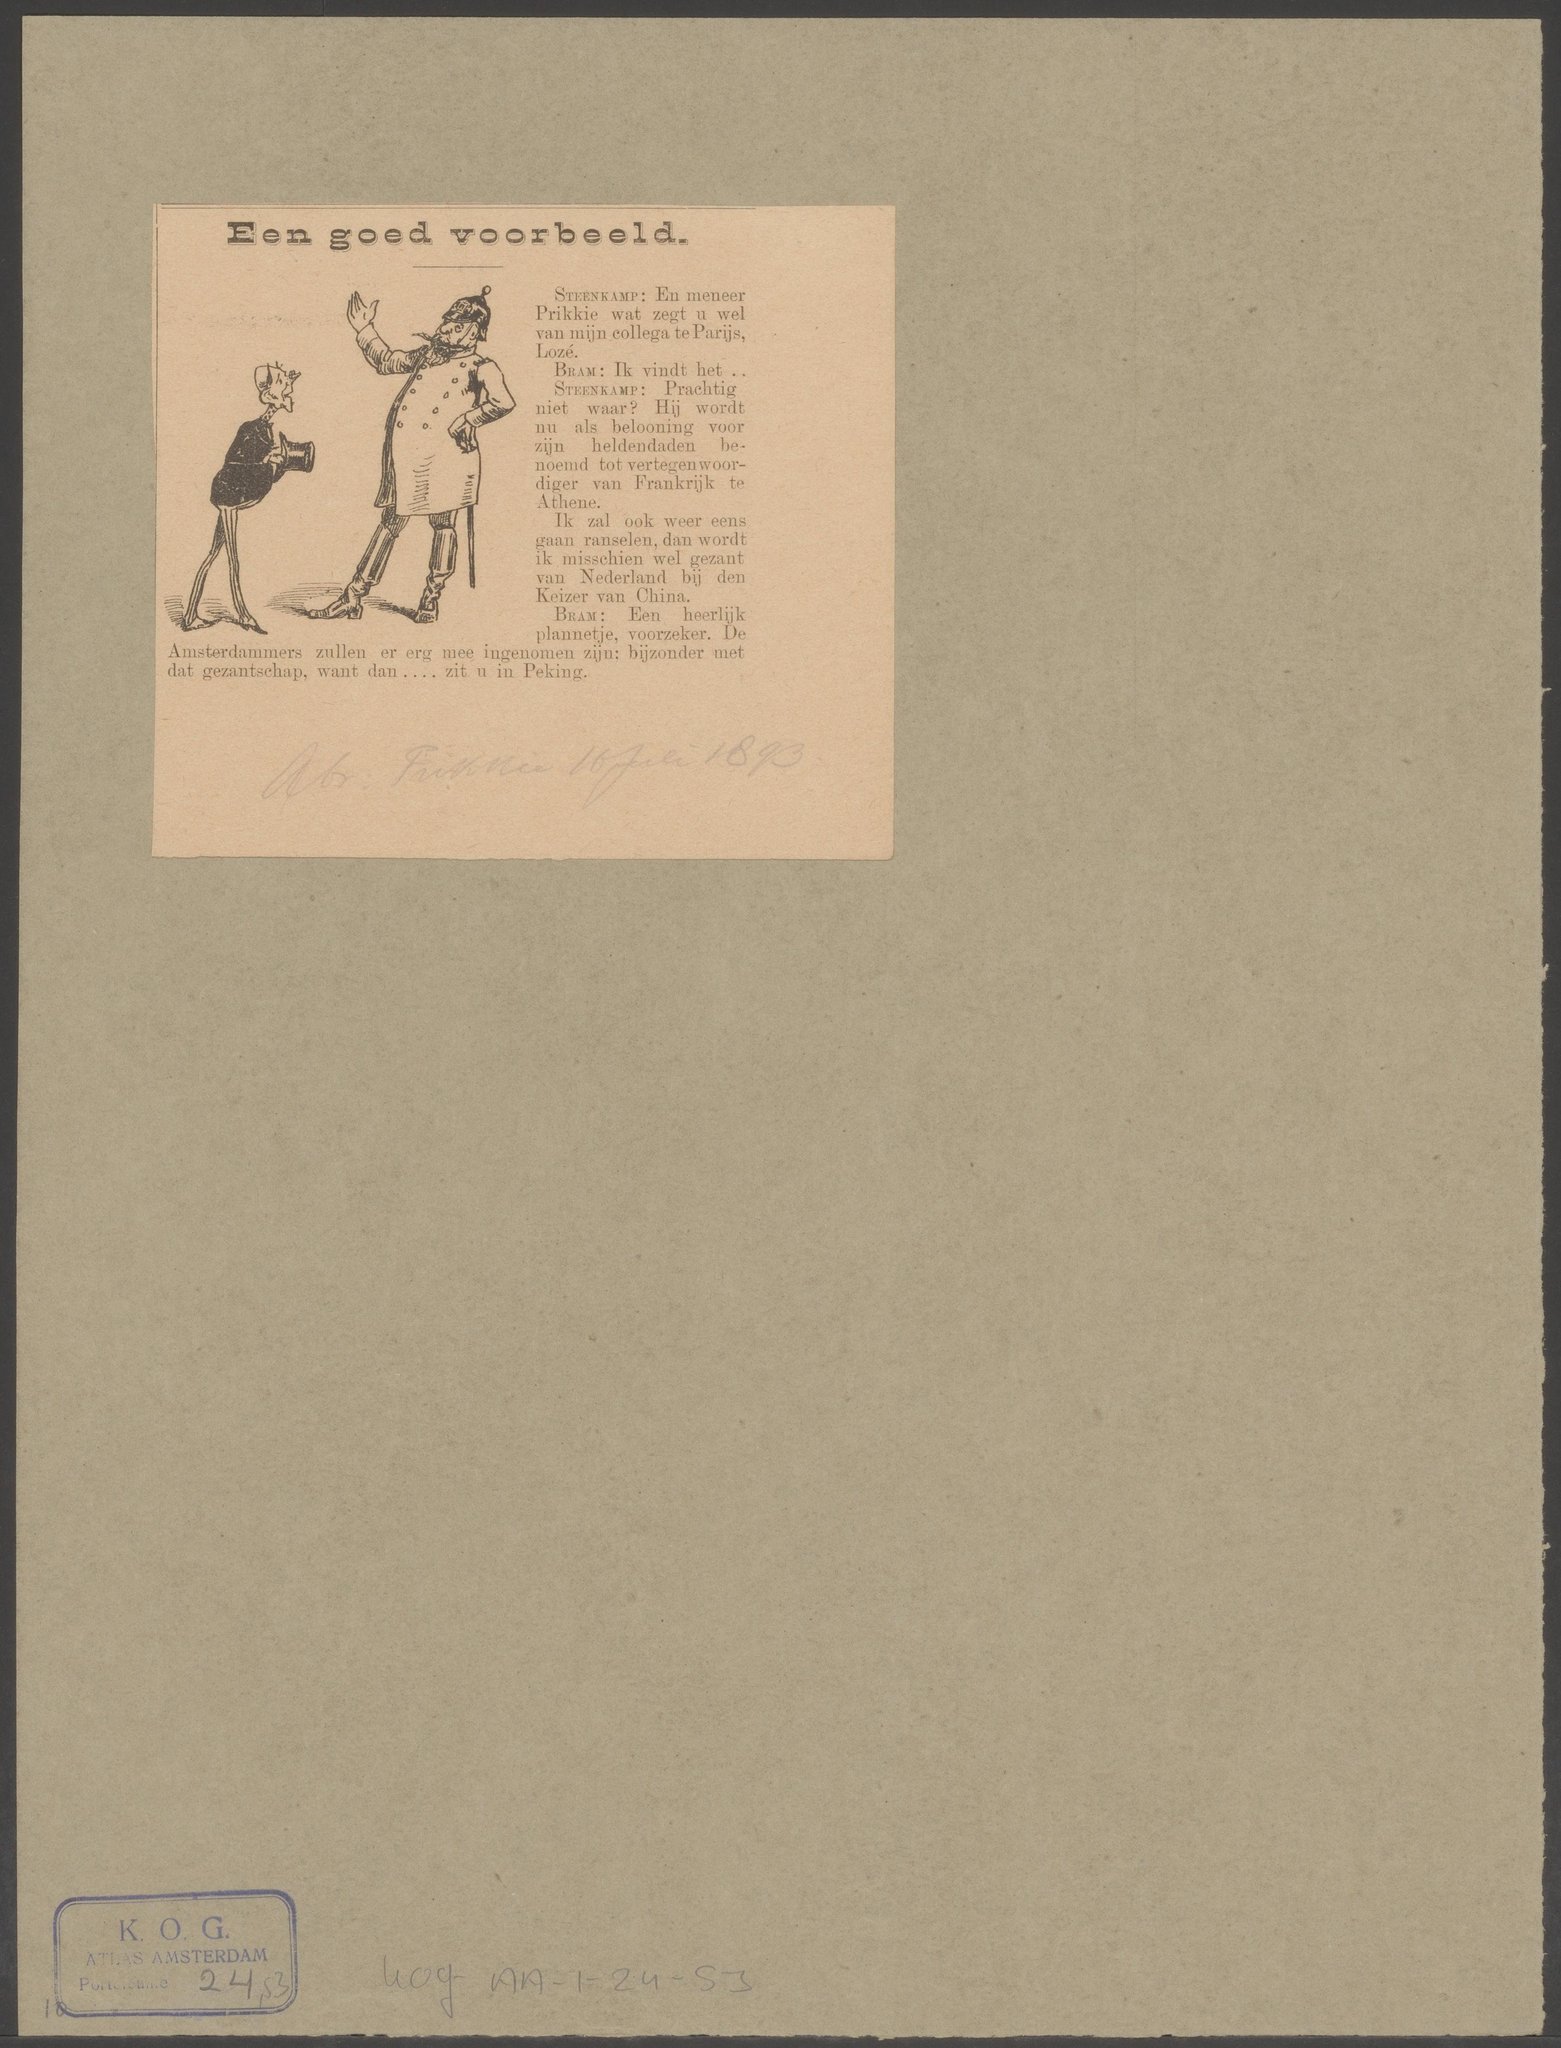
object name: photomechanical print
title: Een goed voorbeeld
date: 1893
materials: paper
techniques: letterpress printing, line block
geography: netherlands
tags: paris, politician, conversation, dialogue; conversation piece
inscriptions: collector's mark: Lugt 1641b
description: Prent uit: Abraham Prikkie's op- en aanmerkingen, 16 juli 1893.